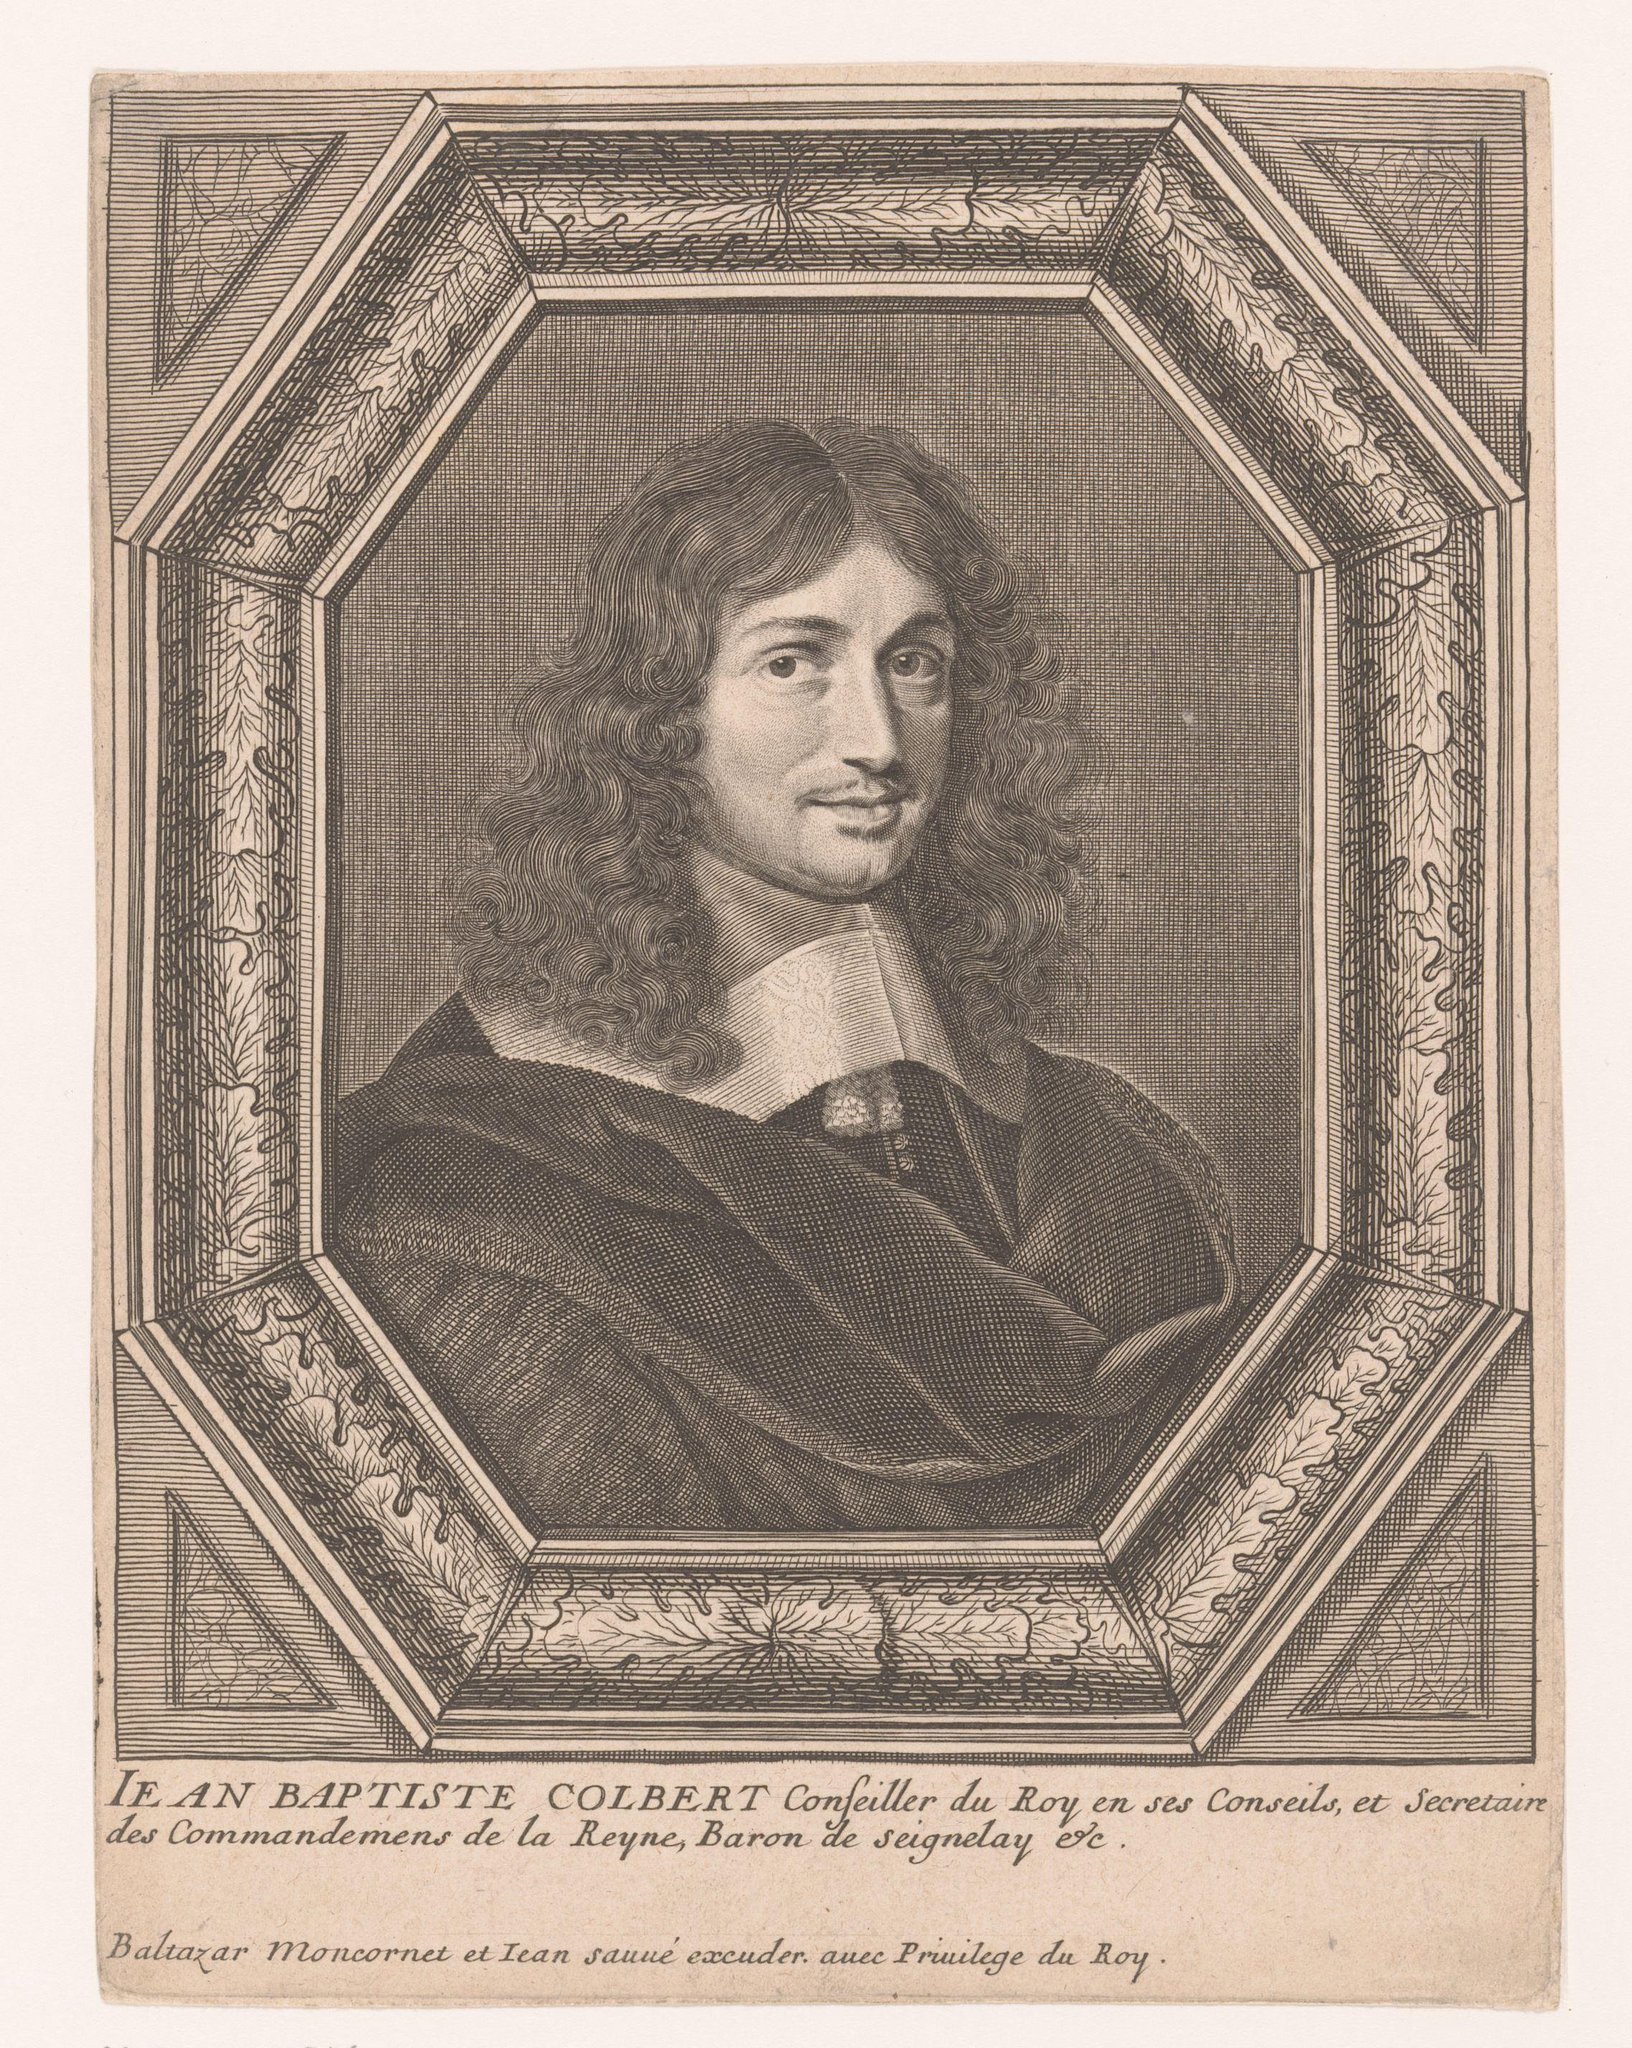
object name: print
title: Portret van Jean-Baptiste Colbert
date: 1610-1668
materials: paper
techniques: engraving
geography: paris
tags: paris, politician, jean-baptiste colbert, historical persons, politician, e.g. party leader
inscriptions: collector's mark: Lugt 2228